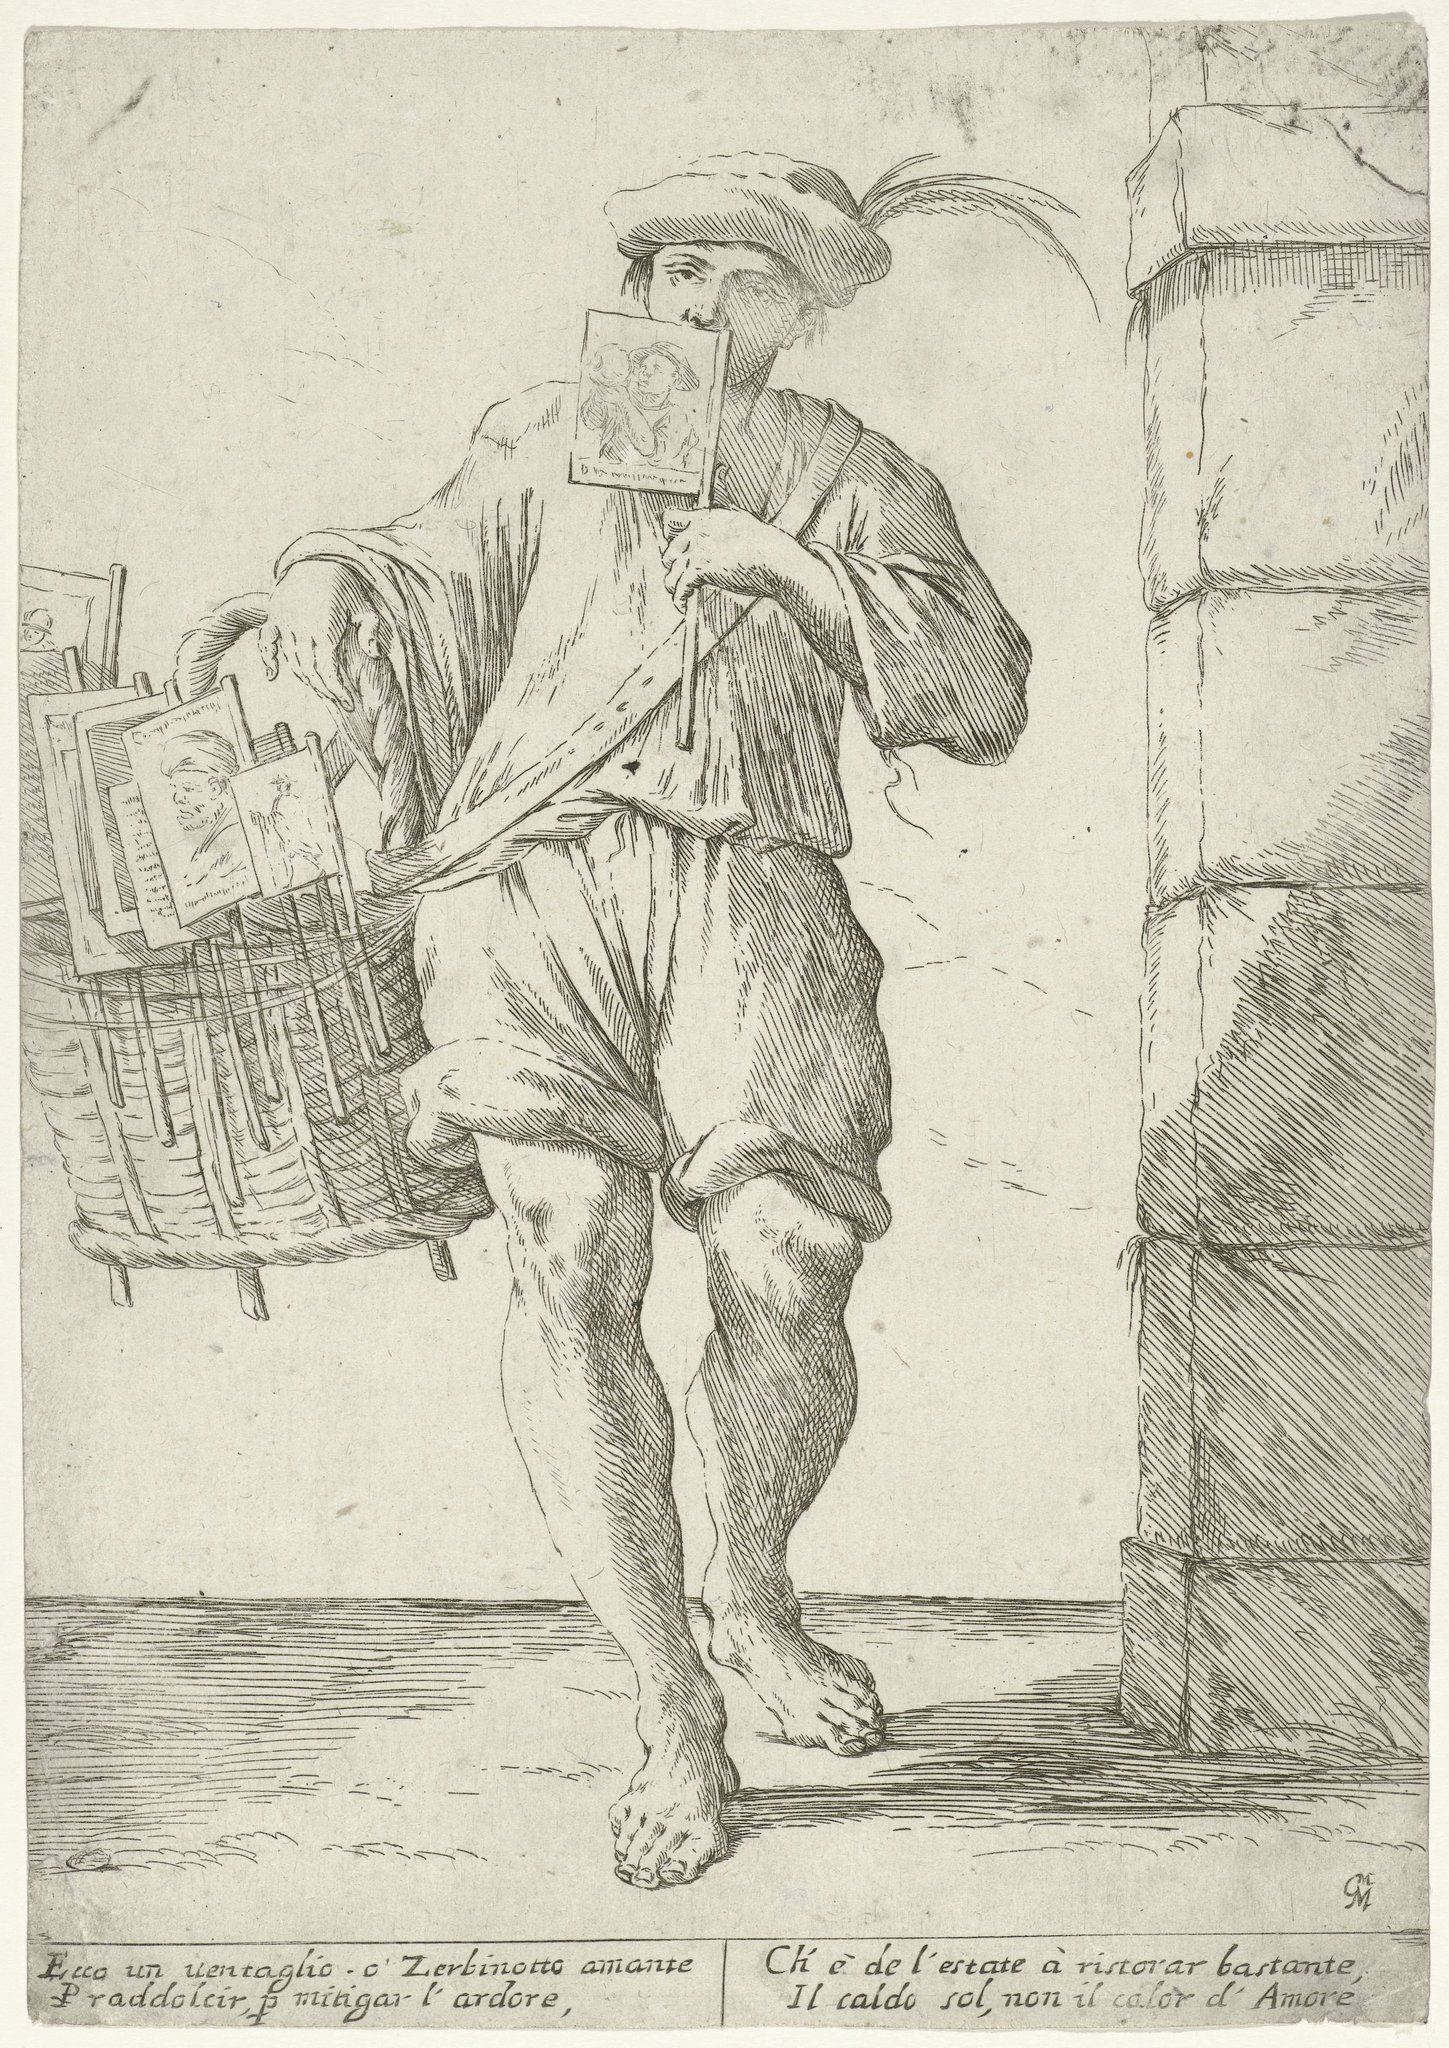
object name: print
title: L'Arti Per Via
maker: giuseppe maria mitelli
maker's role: draughtsman, painter, print maker, publisher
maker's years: 1634-1718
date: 1660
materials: paper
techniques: etching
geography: italy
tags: fan, street-trader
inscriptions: collector's mark: Lugt 2228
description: Een straatverkoper met aan zijn arm een mand met vlaggetjes of waaiers. Italiaans vers in ondermarge.